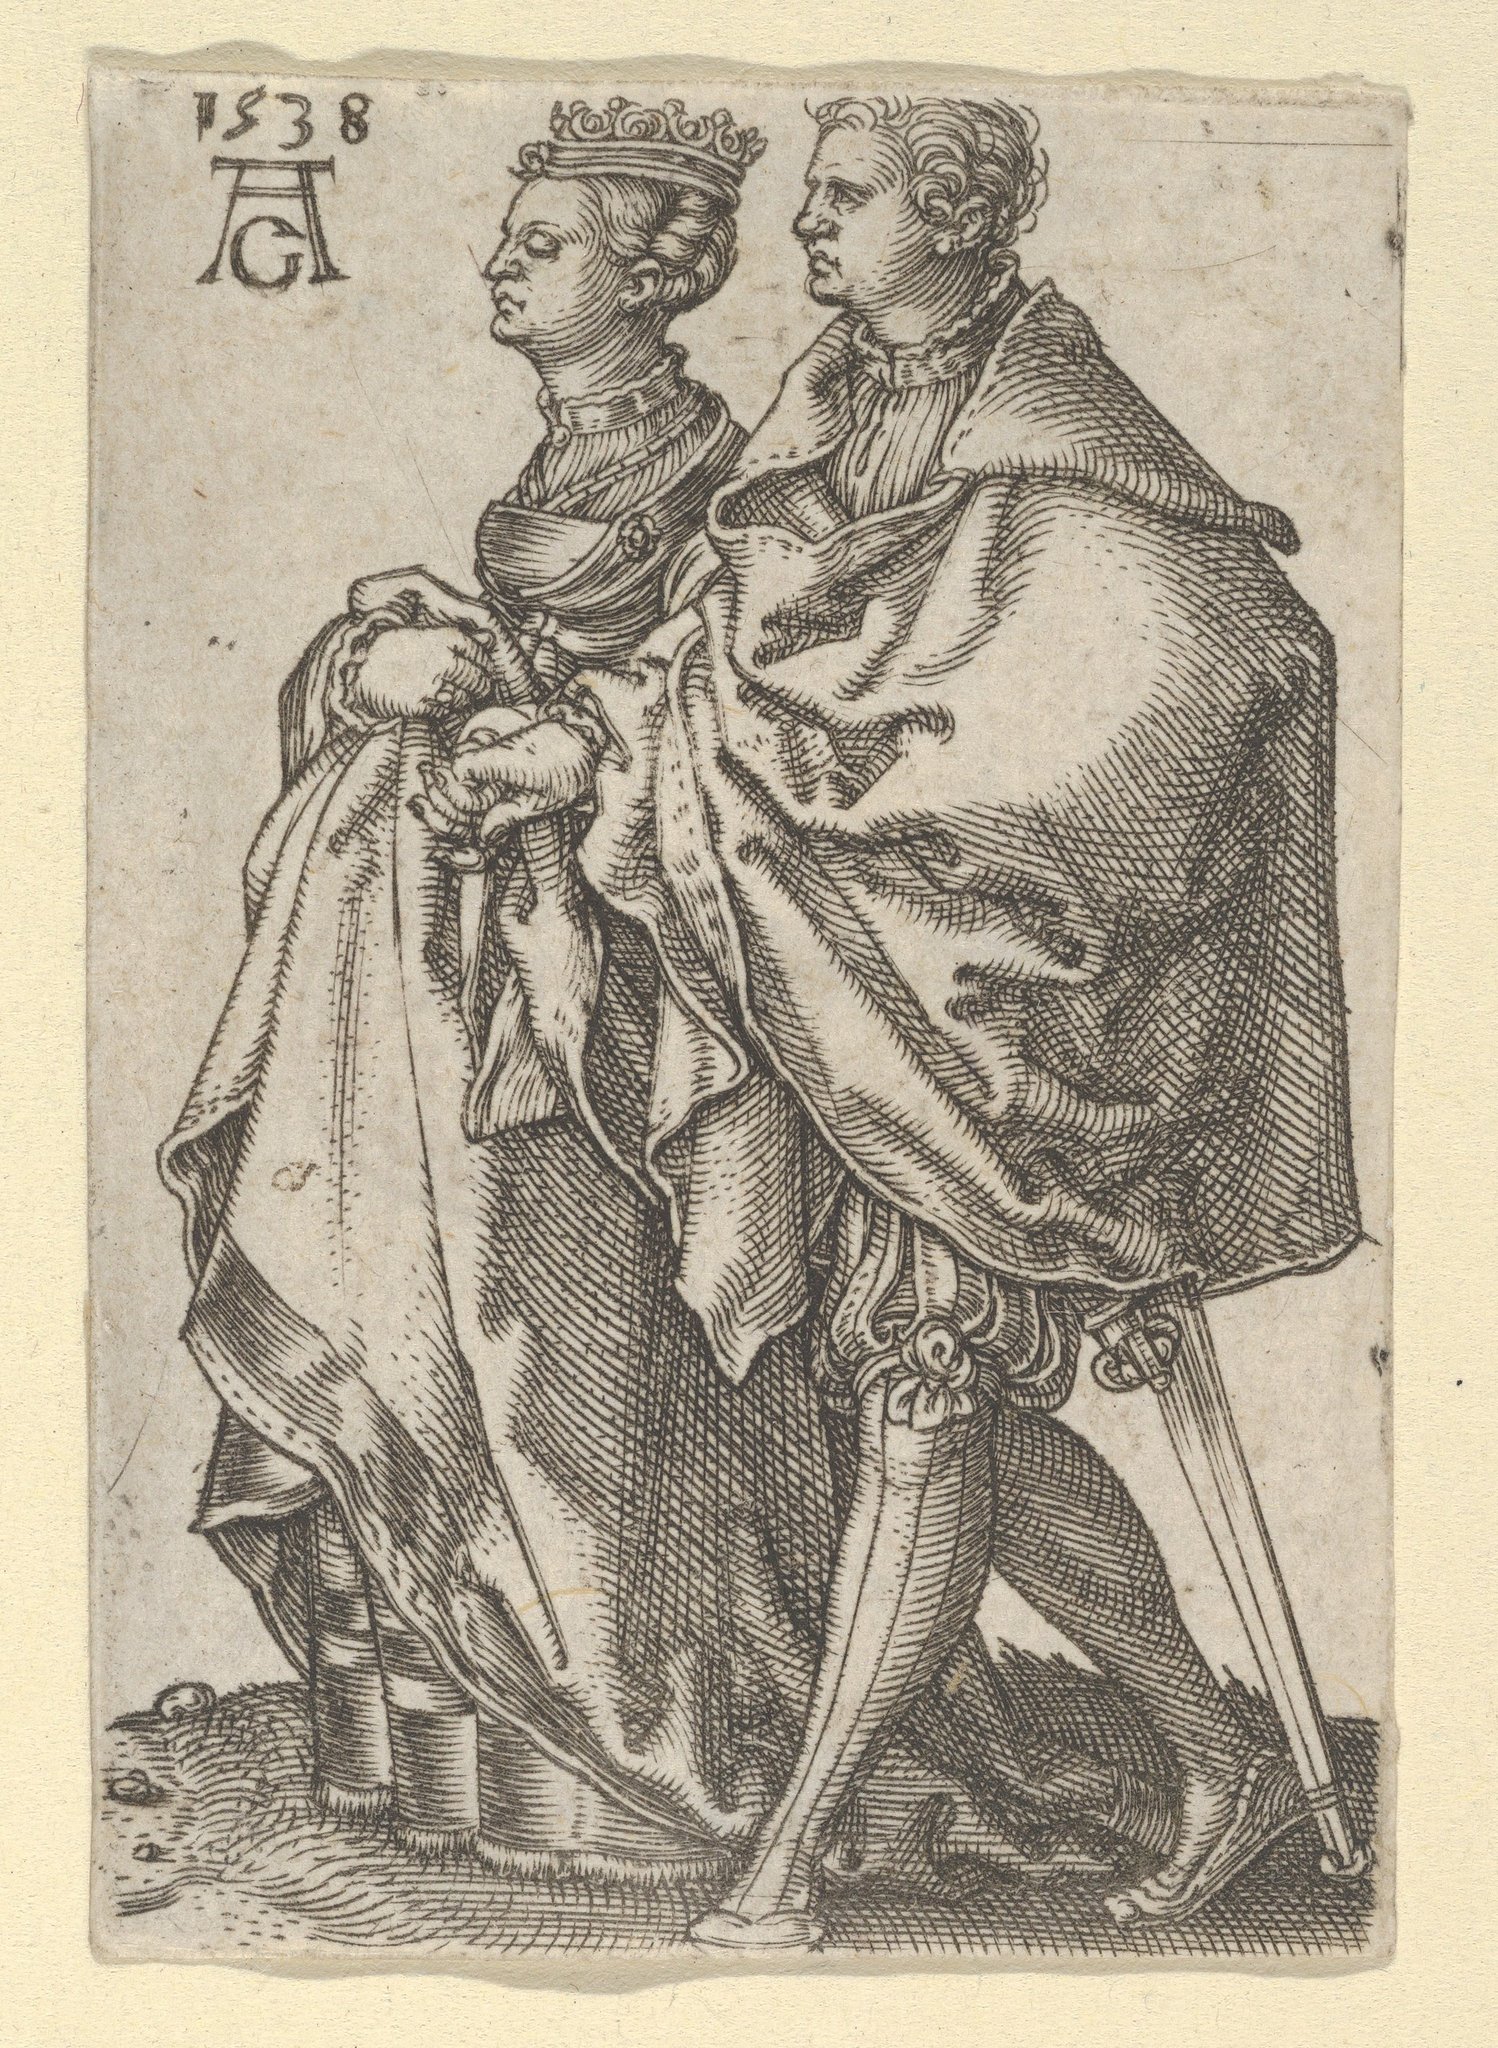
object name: print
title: Dancing Couple Stepping to the Left, from "The Small Wedding Dancers"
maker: heinrich aldegrever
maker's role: artist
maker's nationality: german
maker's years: 1502-1561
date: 1538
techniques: engraving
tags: couples,dancers